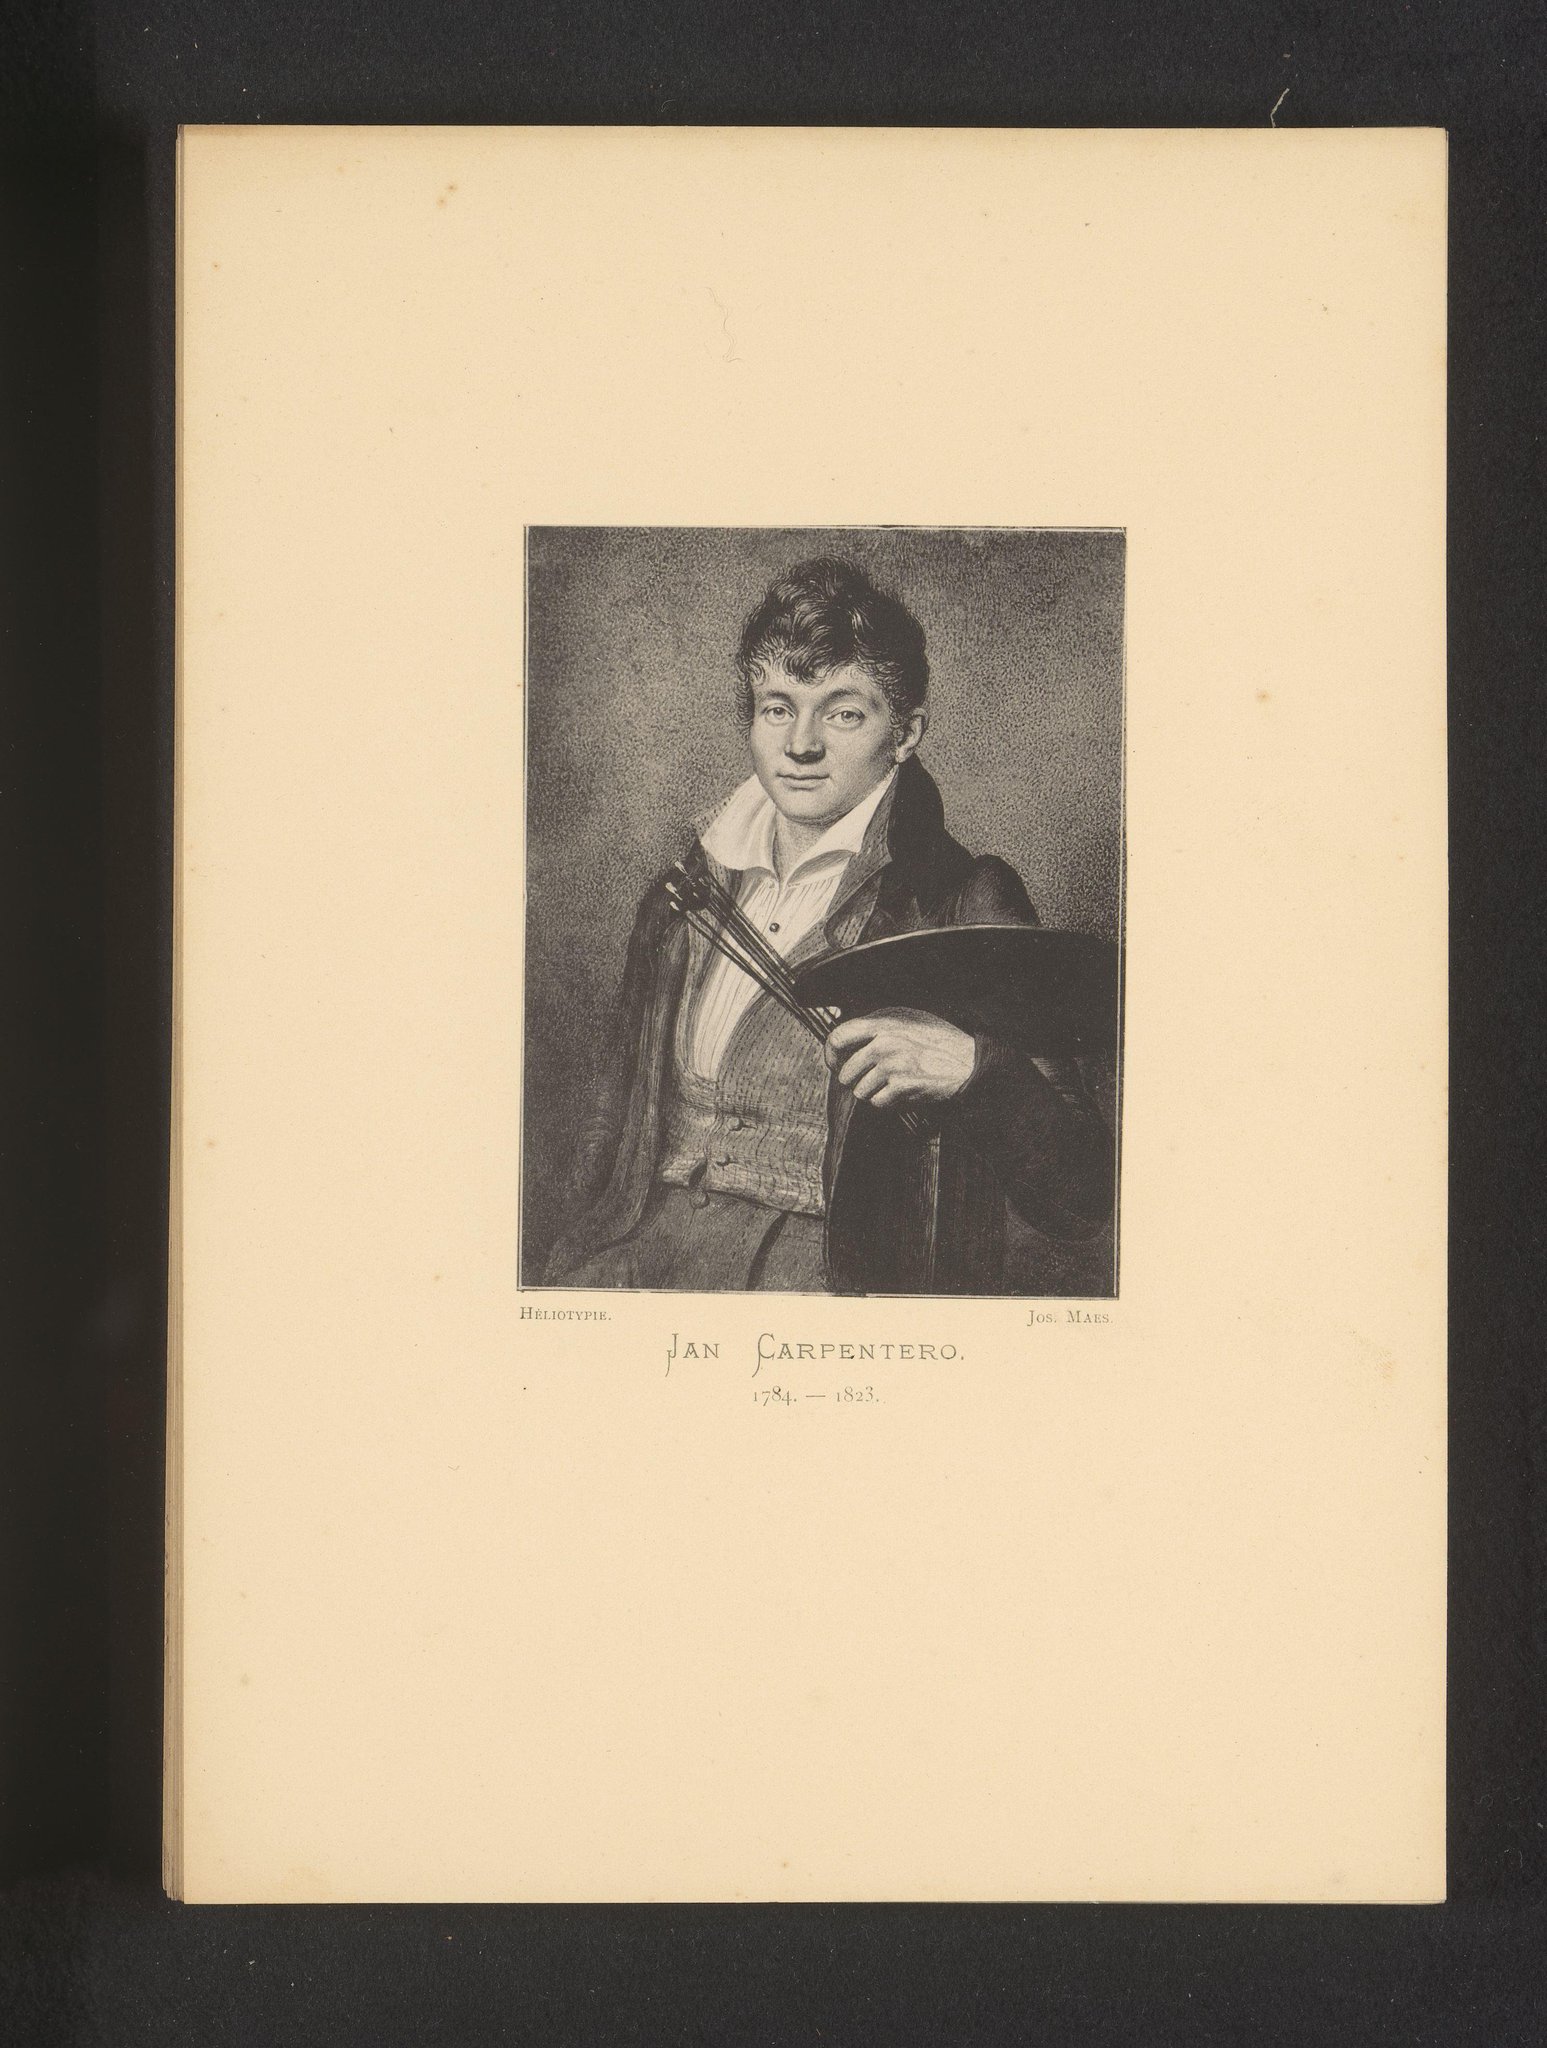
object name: reproduction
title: Reproductie van een gravure van een portret van Jean Charles Carpentero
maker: joseph maes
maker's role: fotograaf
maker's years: 1838-1908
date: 1872-1877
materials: cardboard, paper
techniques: photograph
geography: antwerp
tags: antwerp, painter, historical persons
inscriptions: inscription: ‘1784. - 1823.’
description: Deze prent maakt deel uit van een omslag met 150 prenten en een katern met een lijst van afbeeldingen.